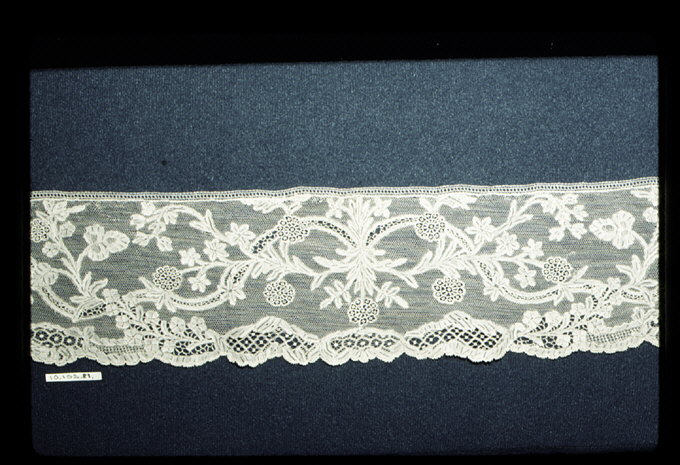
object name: fragment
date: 1701-1733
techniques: lace